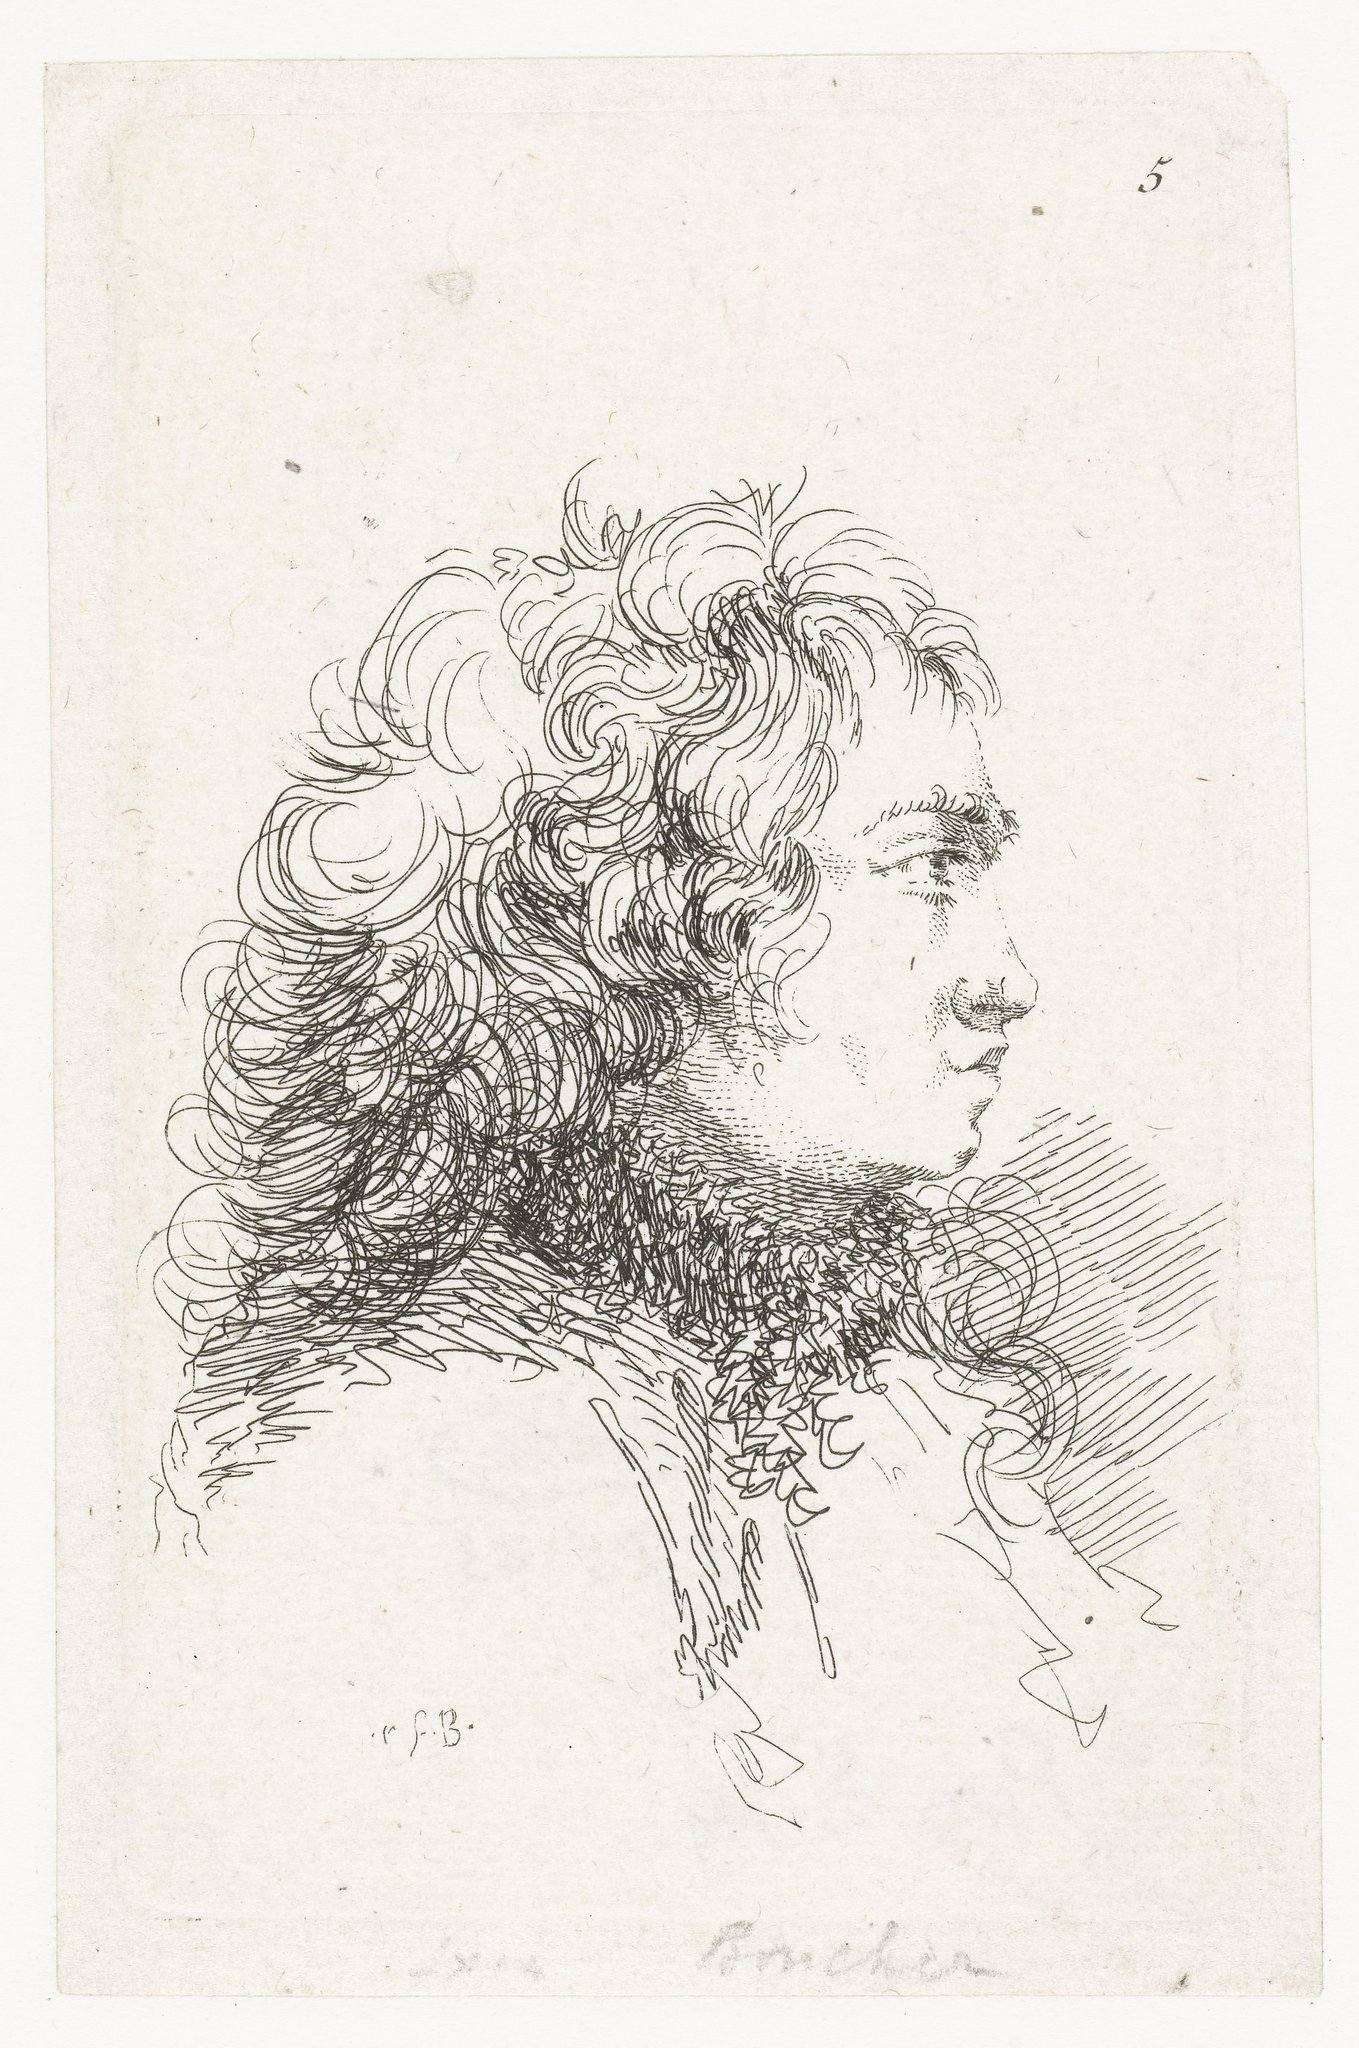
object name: print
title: Suite van kleine genrestukjes en koppen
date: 1727-1755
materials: paper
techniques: etching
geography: paris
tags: youth, adolescent (+ sideview, profile)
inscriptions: collector's mark: Lugt 2228, inscription: ‘Boucher’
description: Hoofd van een jongeman met lang haar, en profil naar rechts.